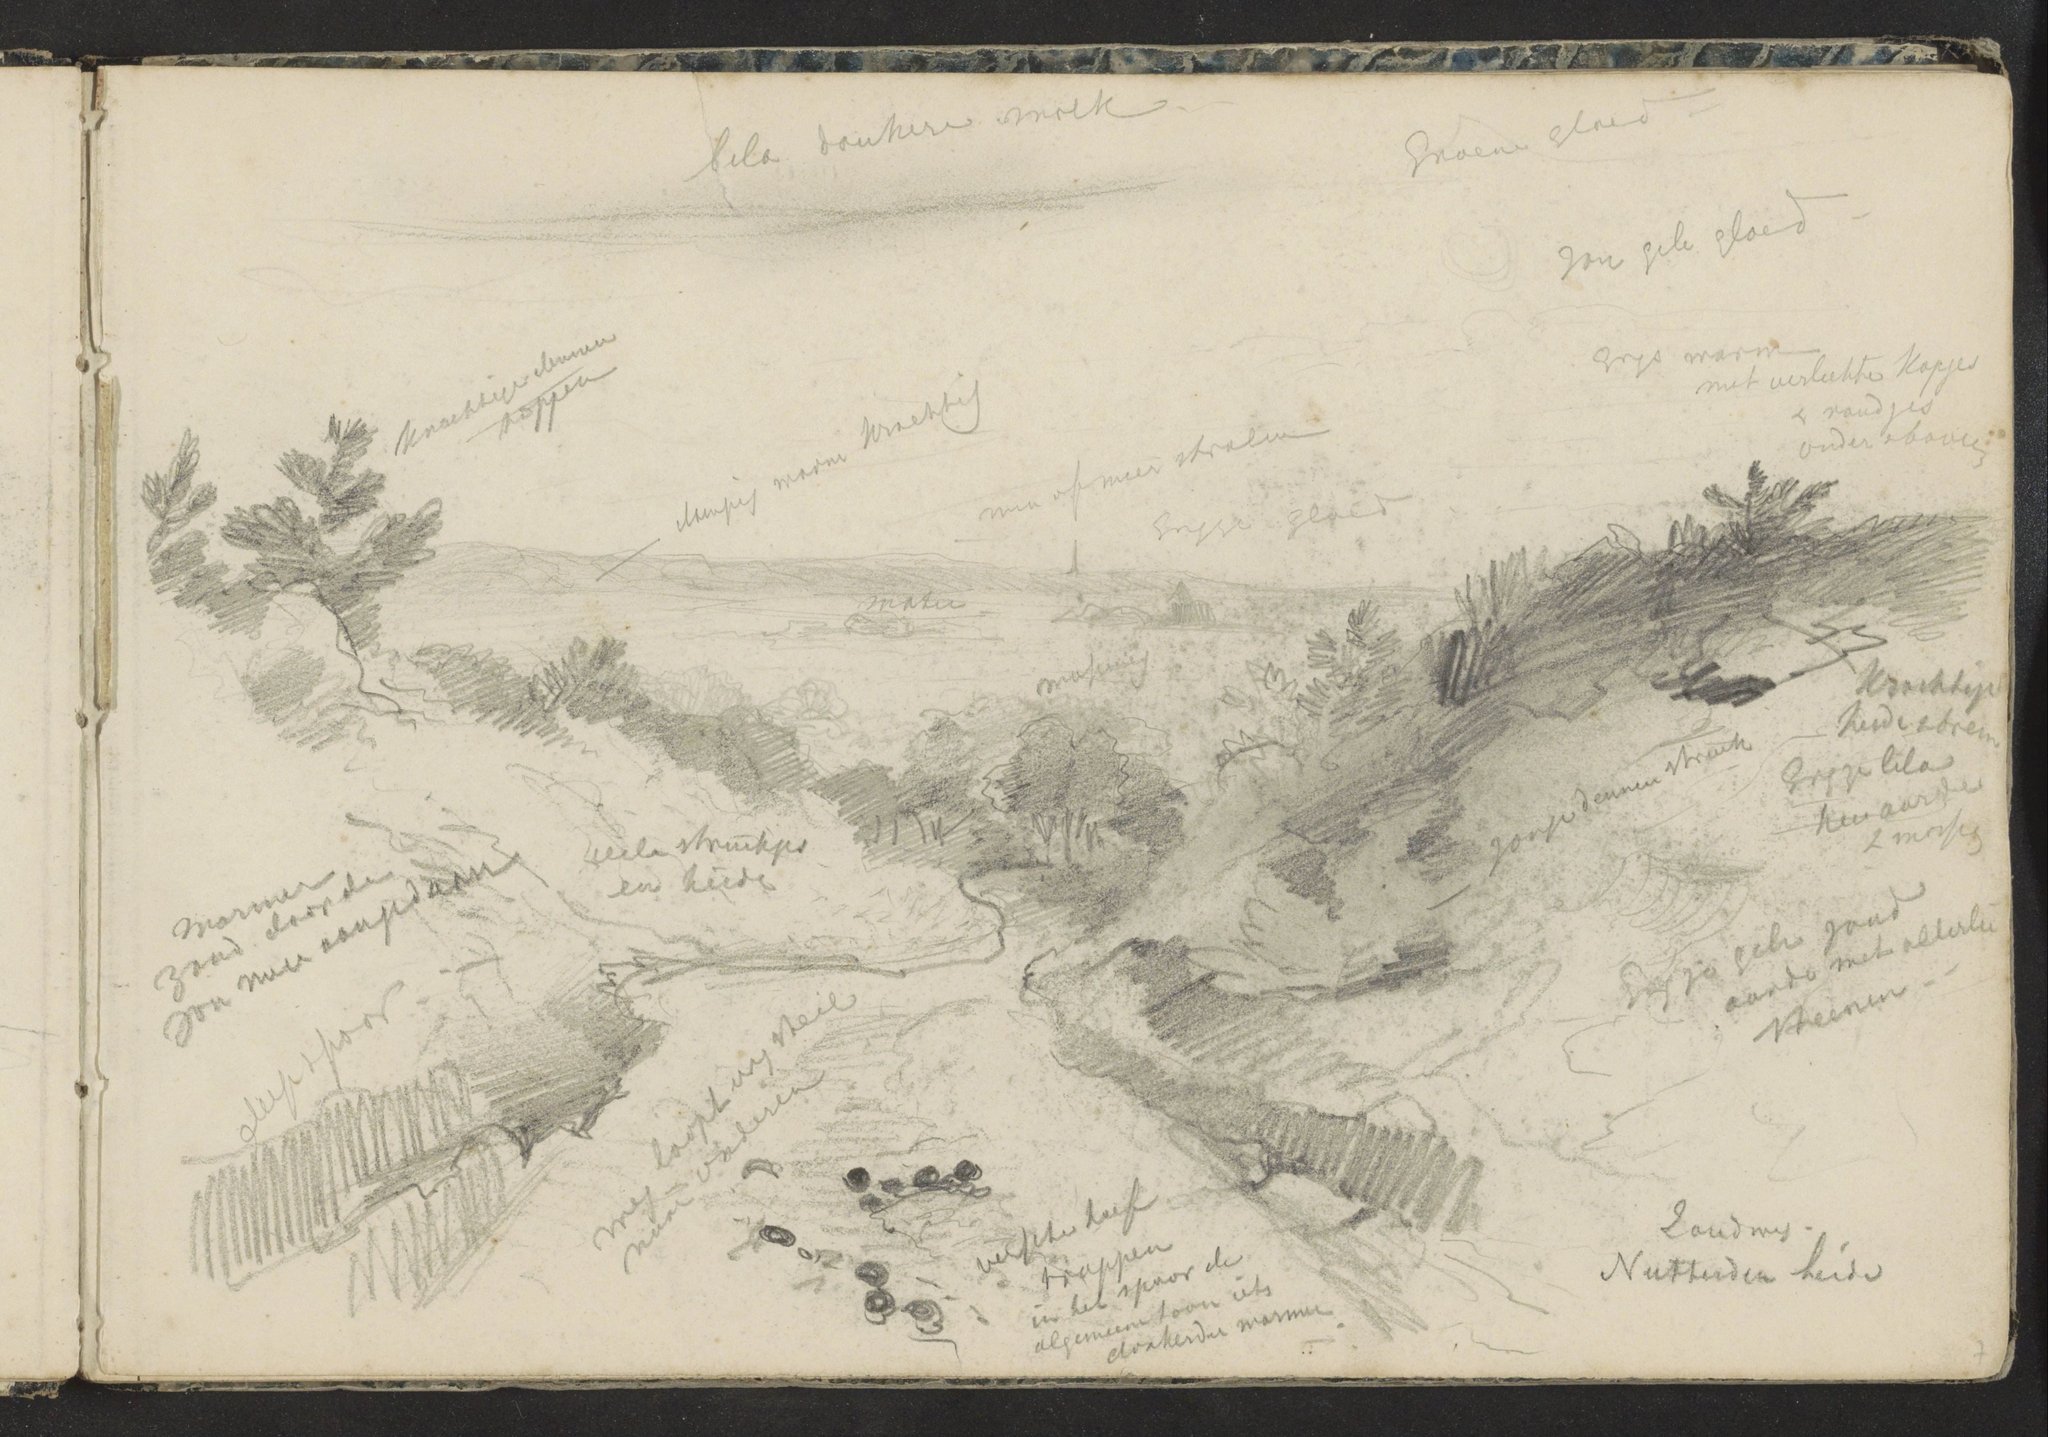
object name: sketchbook leaf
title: Zandweg op de heide van Nütterden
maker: johannes tavenraat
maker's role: draughtsman, painter, print maker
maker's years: 1809-1881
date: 1843-1857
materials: paper, pencil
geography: kranenburg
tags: landscapes, road, path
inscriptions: annotation: ‘Zandweg/ Nutterden heide’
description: Blad 7 recto uit een schetsboek met 44 bladen.